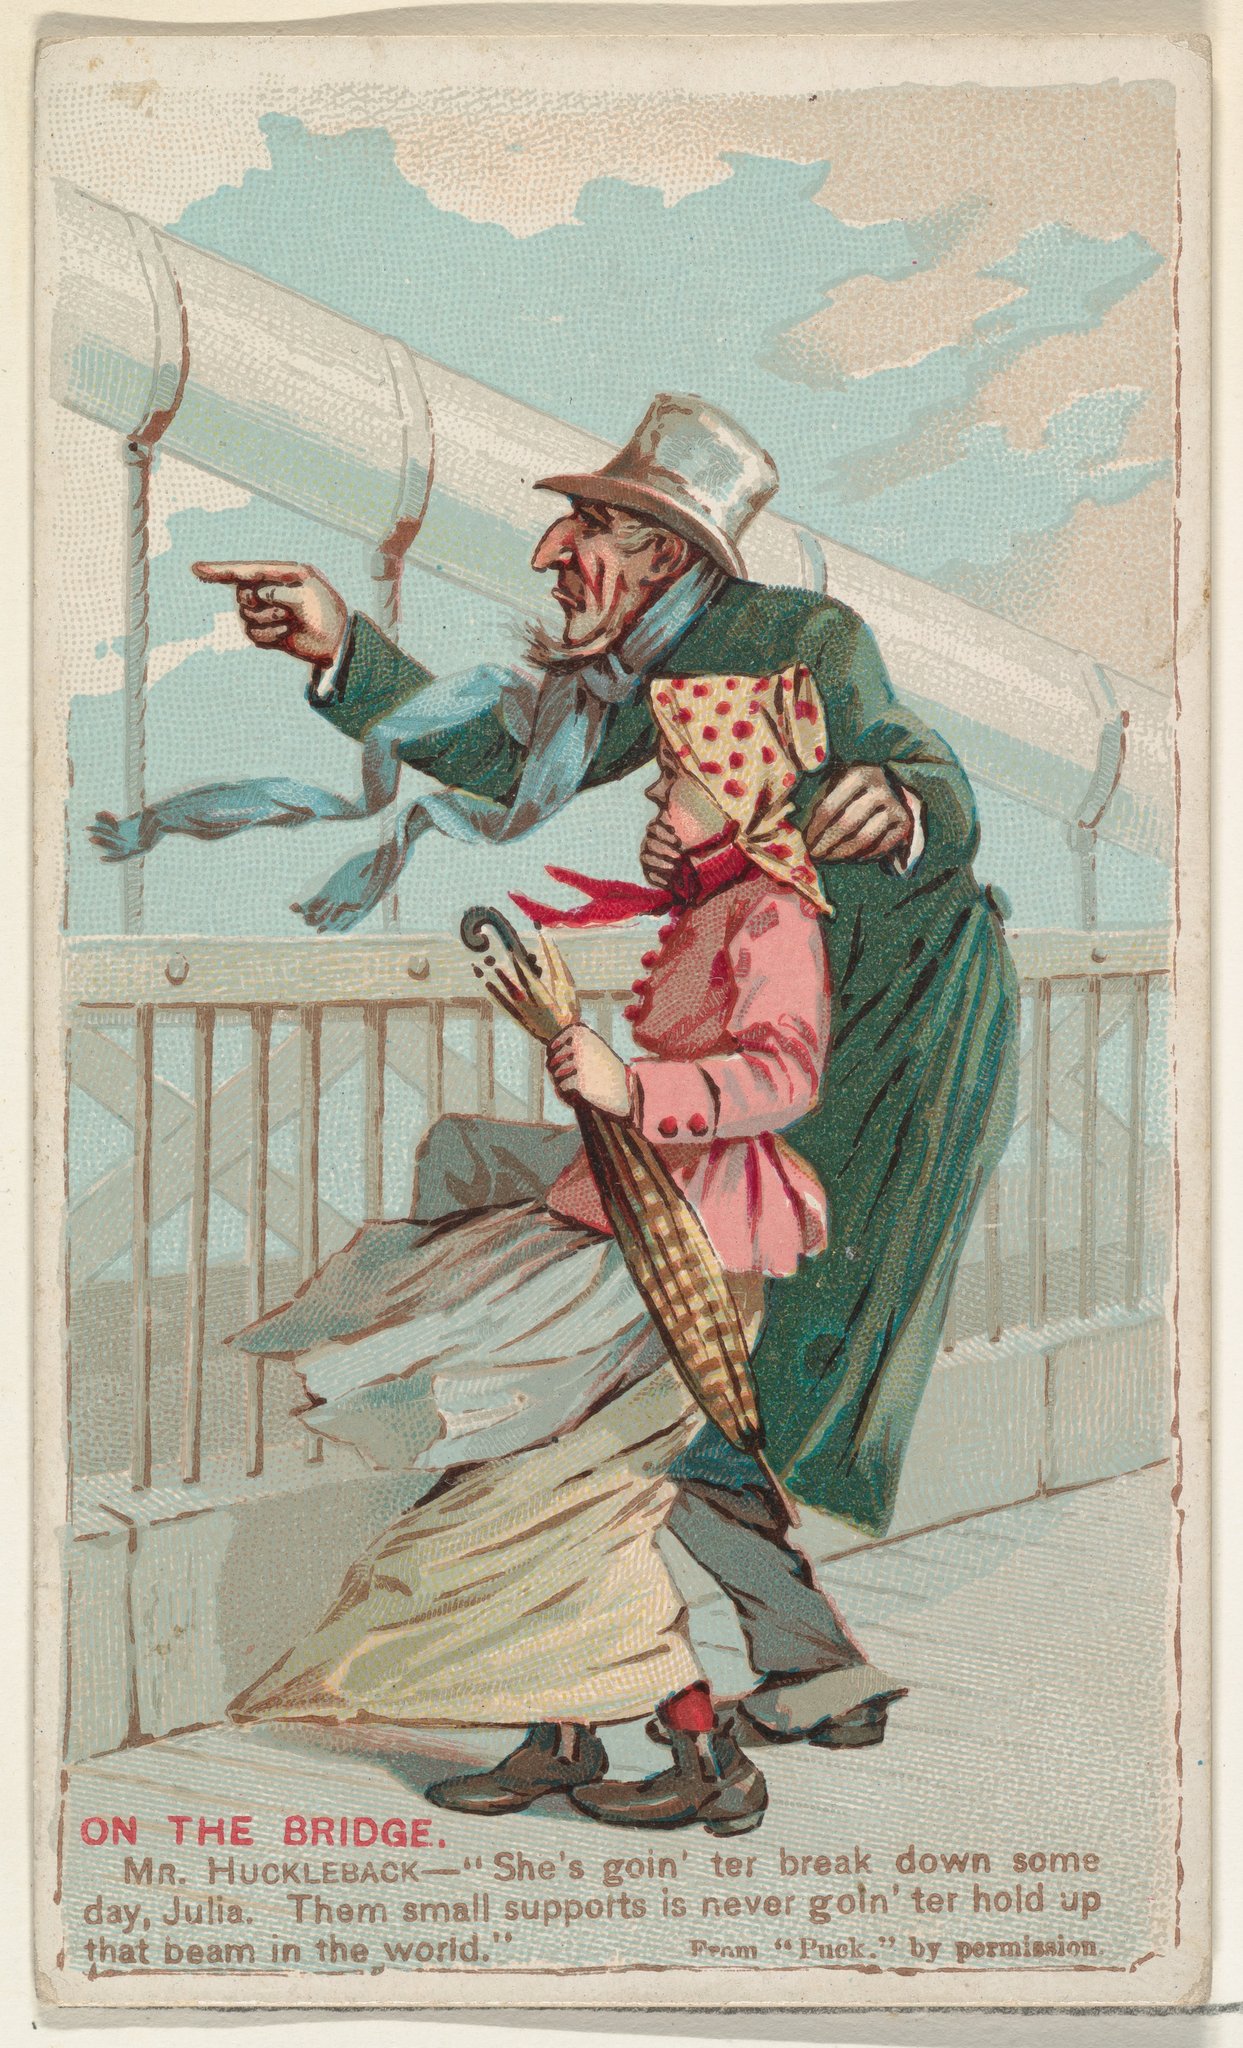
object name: print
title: On the Bridge, from the Snapshots from "Puck" series (N128) issued by Duke Sons & Co. to promote Honest Long Cut Tobacco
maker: w. duke, sons & co.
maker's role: publisher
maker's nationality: american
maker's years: 1870-1920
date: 1888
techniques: color lithograph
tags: bridges,girls,men,profiles